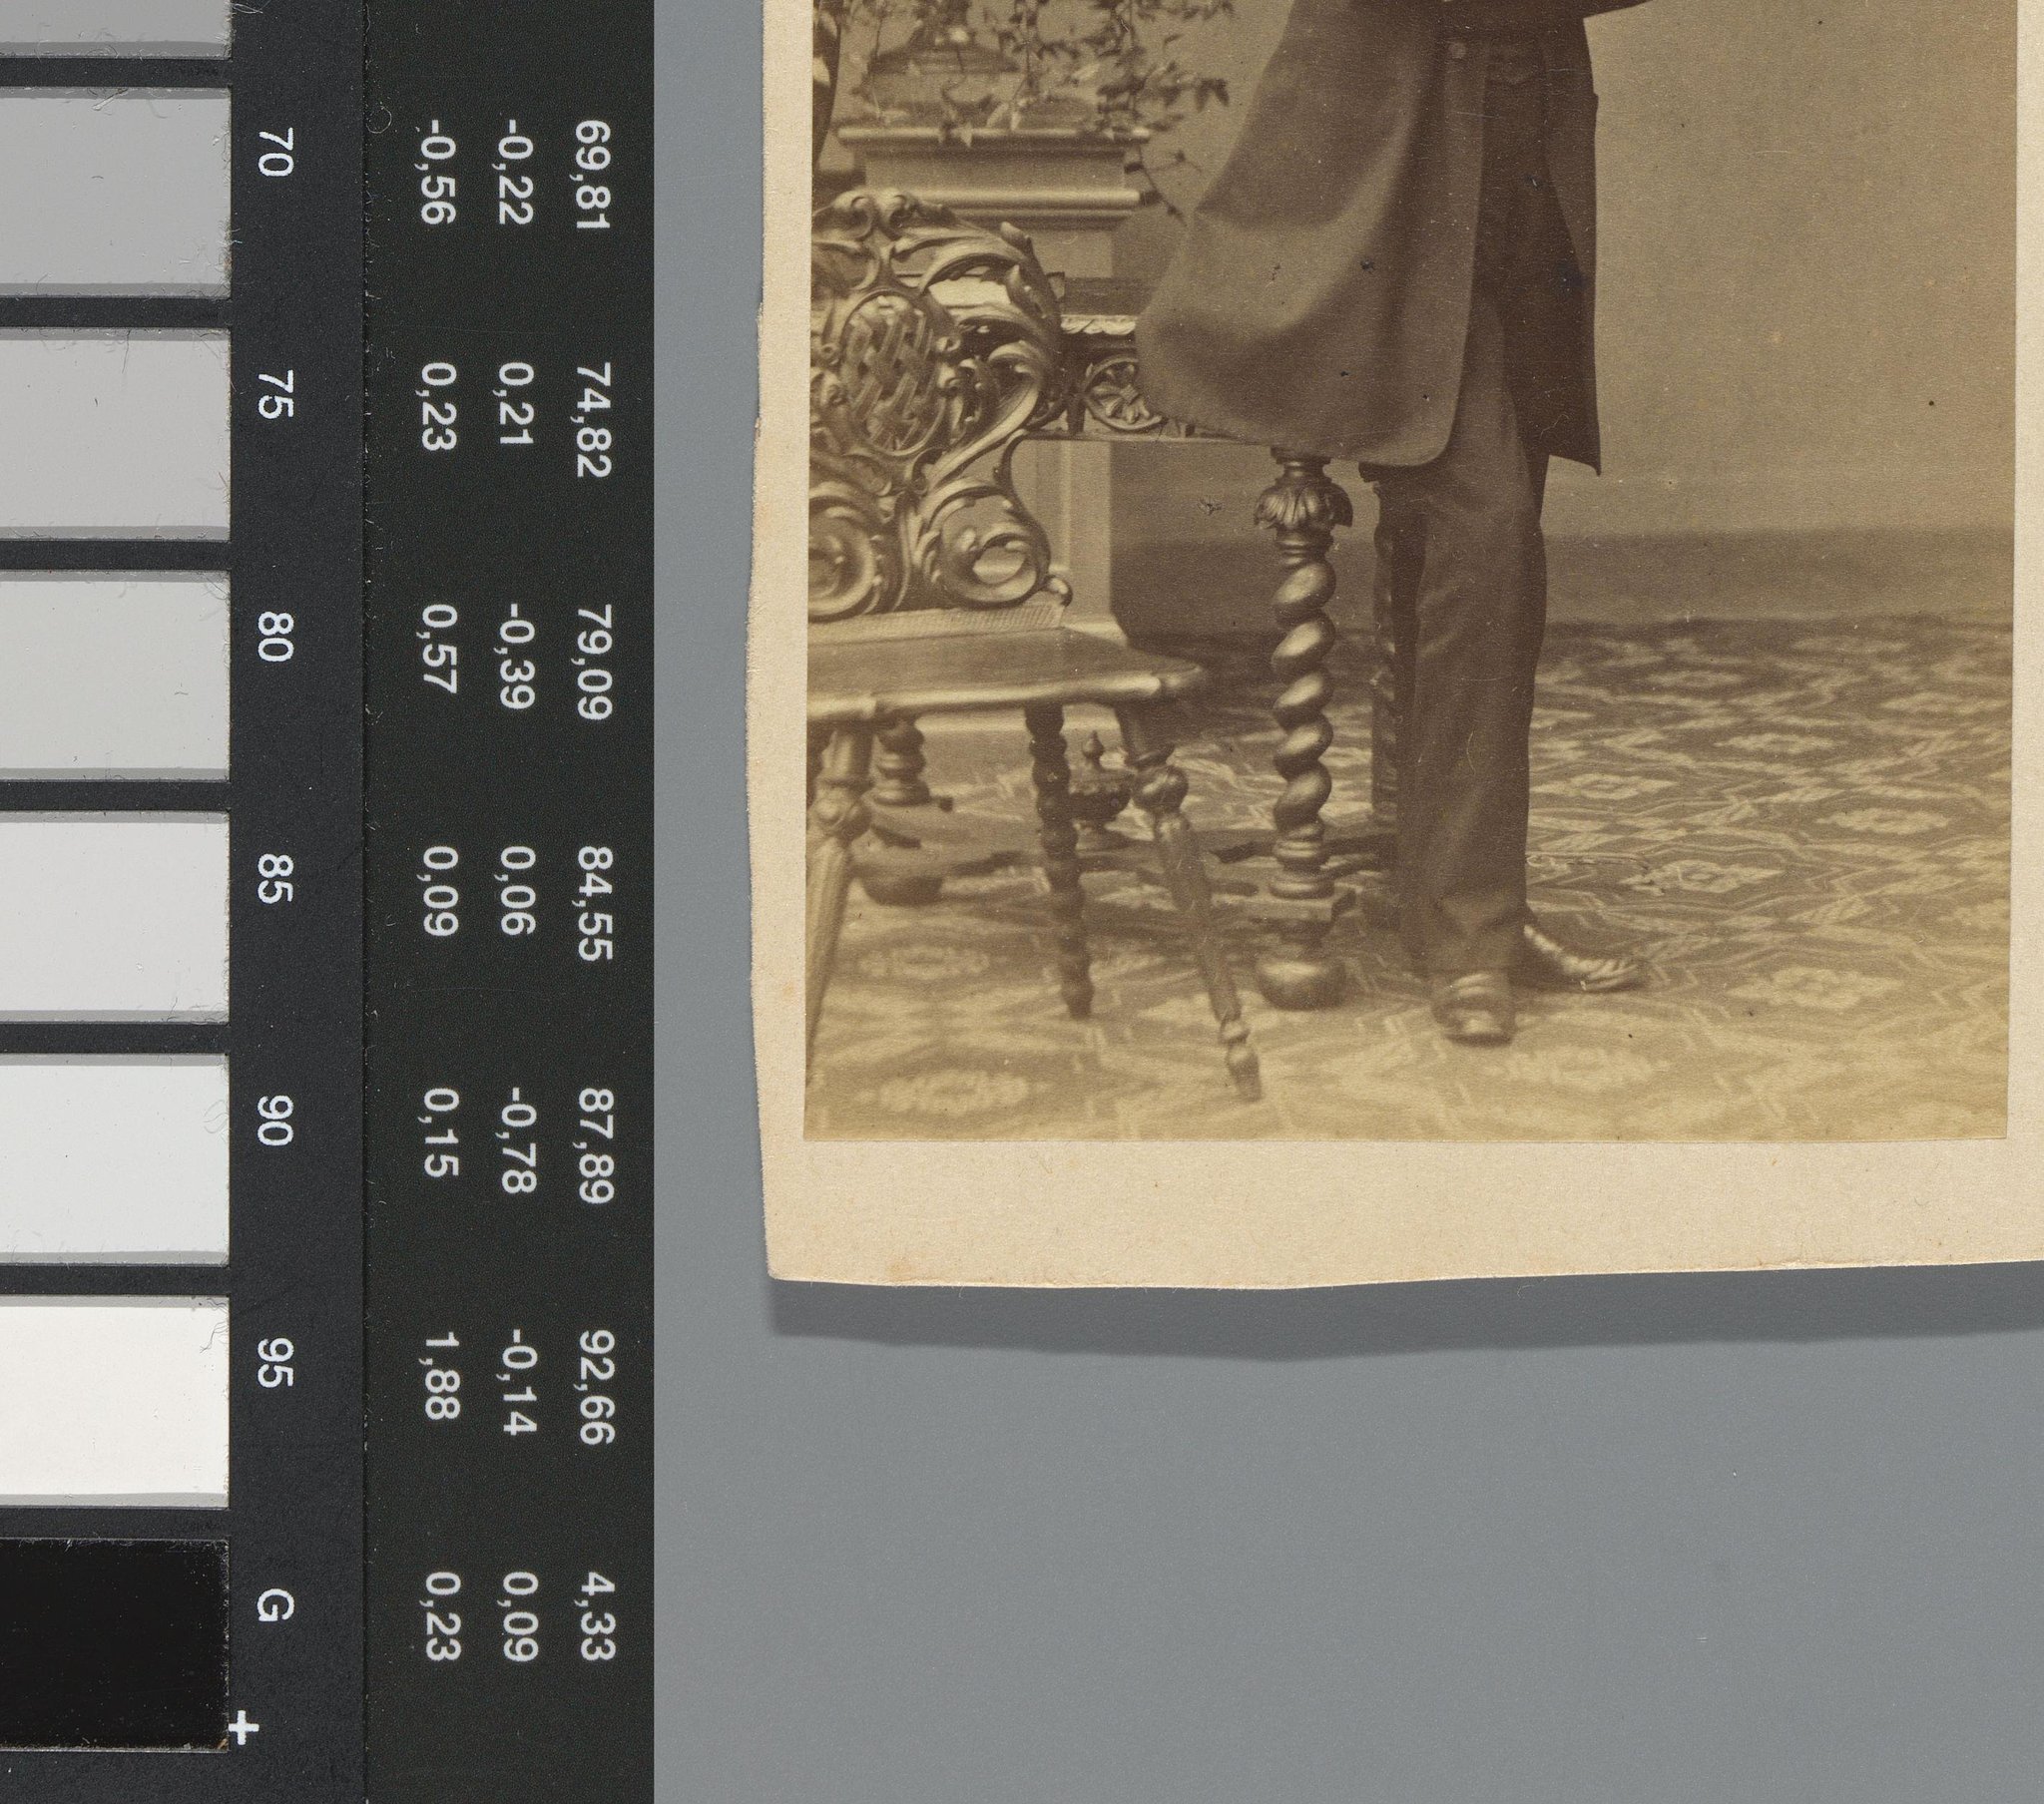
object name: carte de visite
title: Portret van Henri E.C. van Kerckhoff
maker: Anonymous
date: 1855-1910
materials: cardboard, photographic support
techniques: albumen print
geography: netherlands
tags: henri e.c. kerckhoff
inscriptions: name: ‘mr H.E.C. / van Kerckhoff’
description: Staande man met over elkaar geslagen armen.